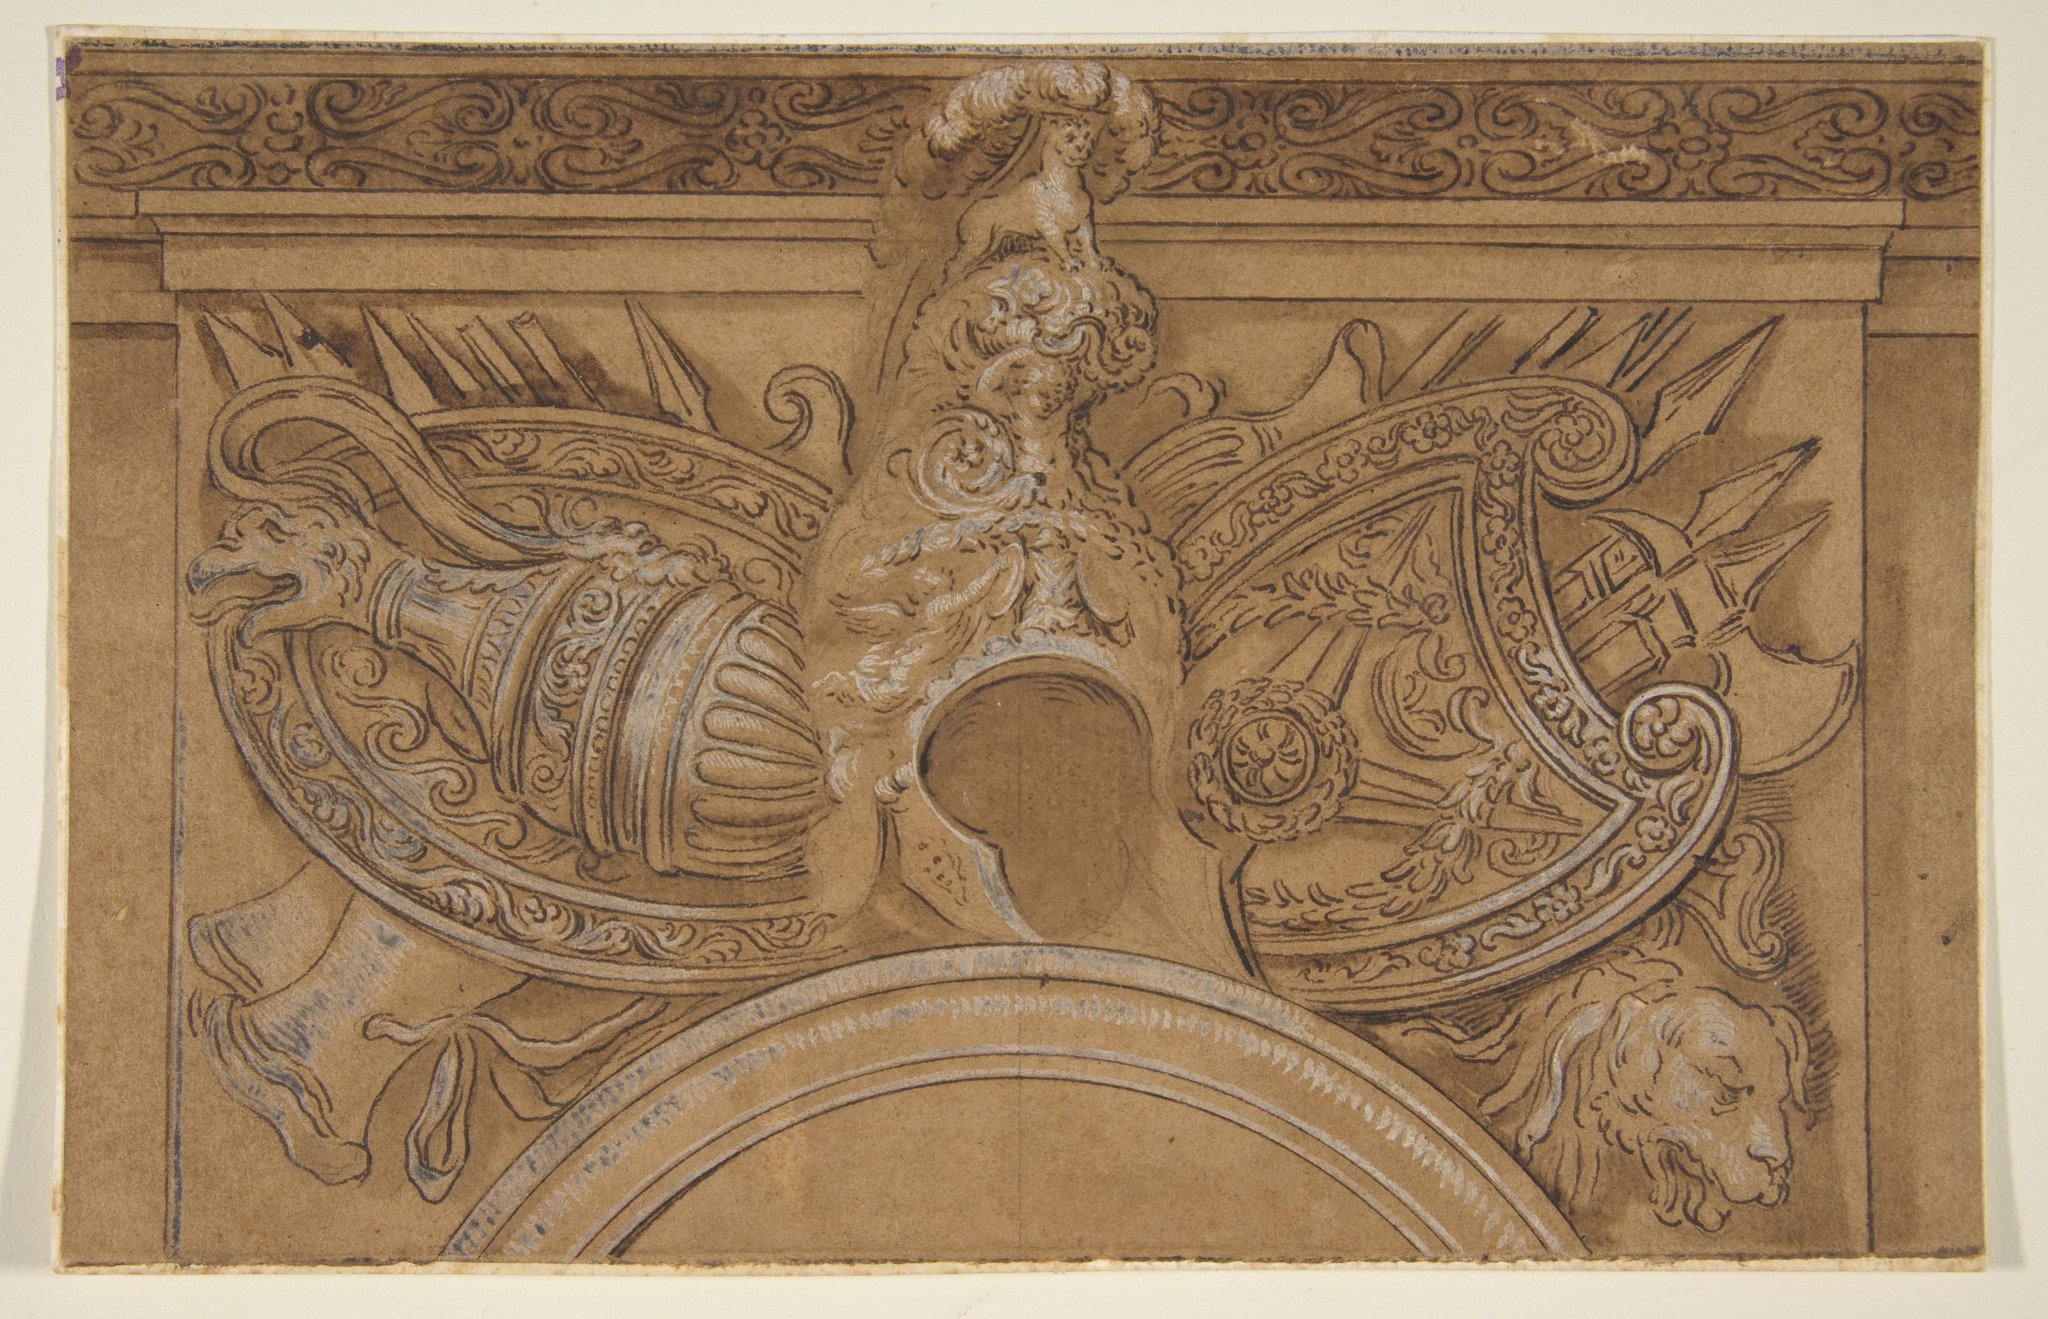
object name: drawing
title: Armorial Trophy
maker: polidoro da caravaggio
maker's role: artist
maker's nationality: italian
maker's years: 1494-1548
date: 1600-1800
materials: graphite, ink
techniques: brush, heightening, pen, wash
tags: shields,weapons,lions,trophies